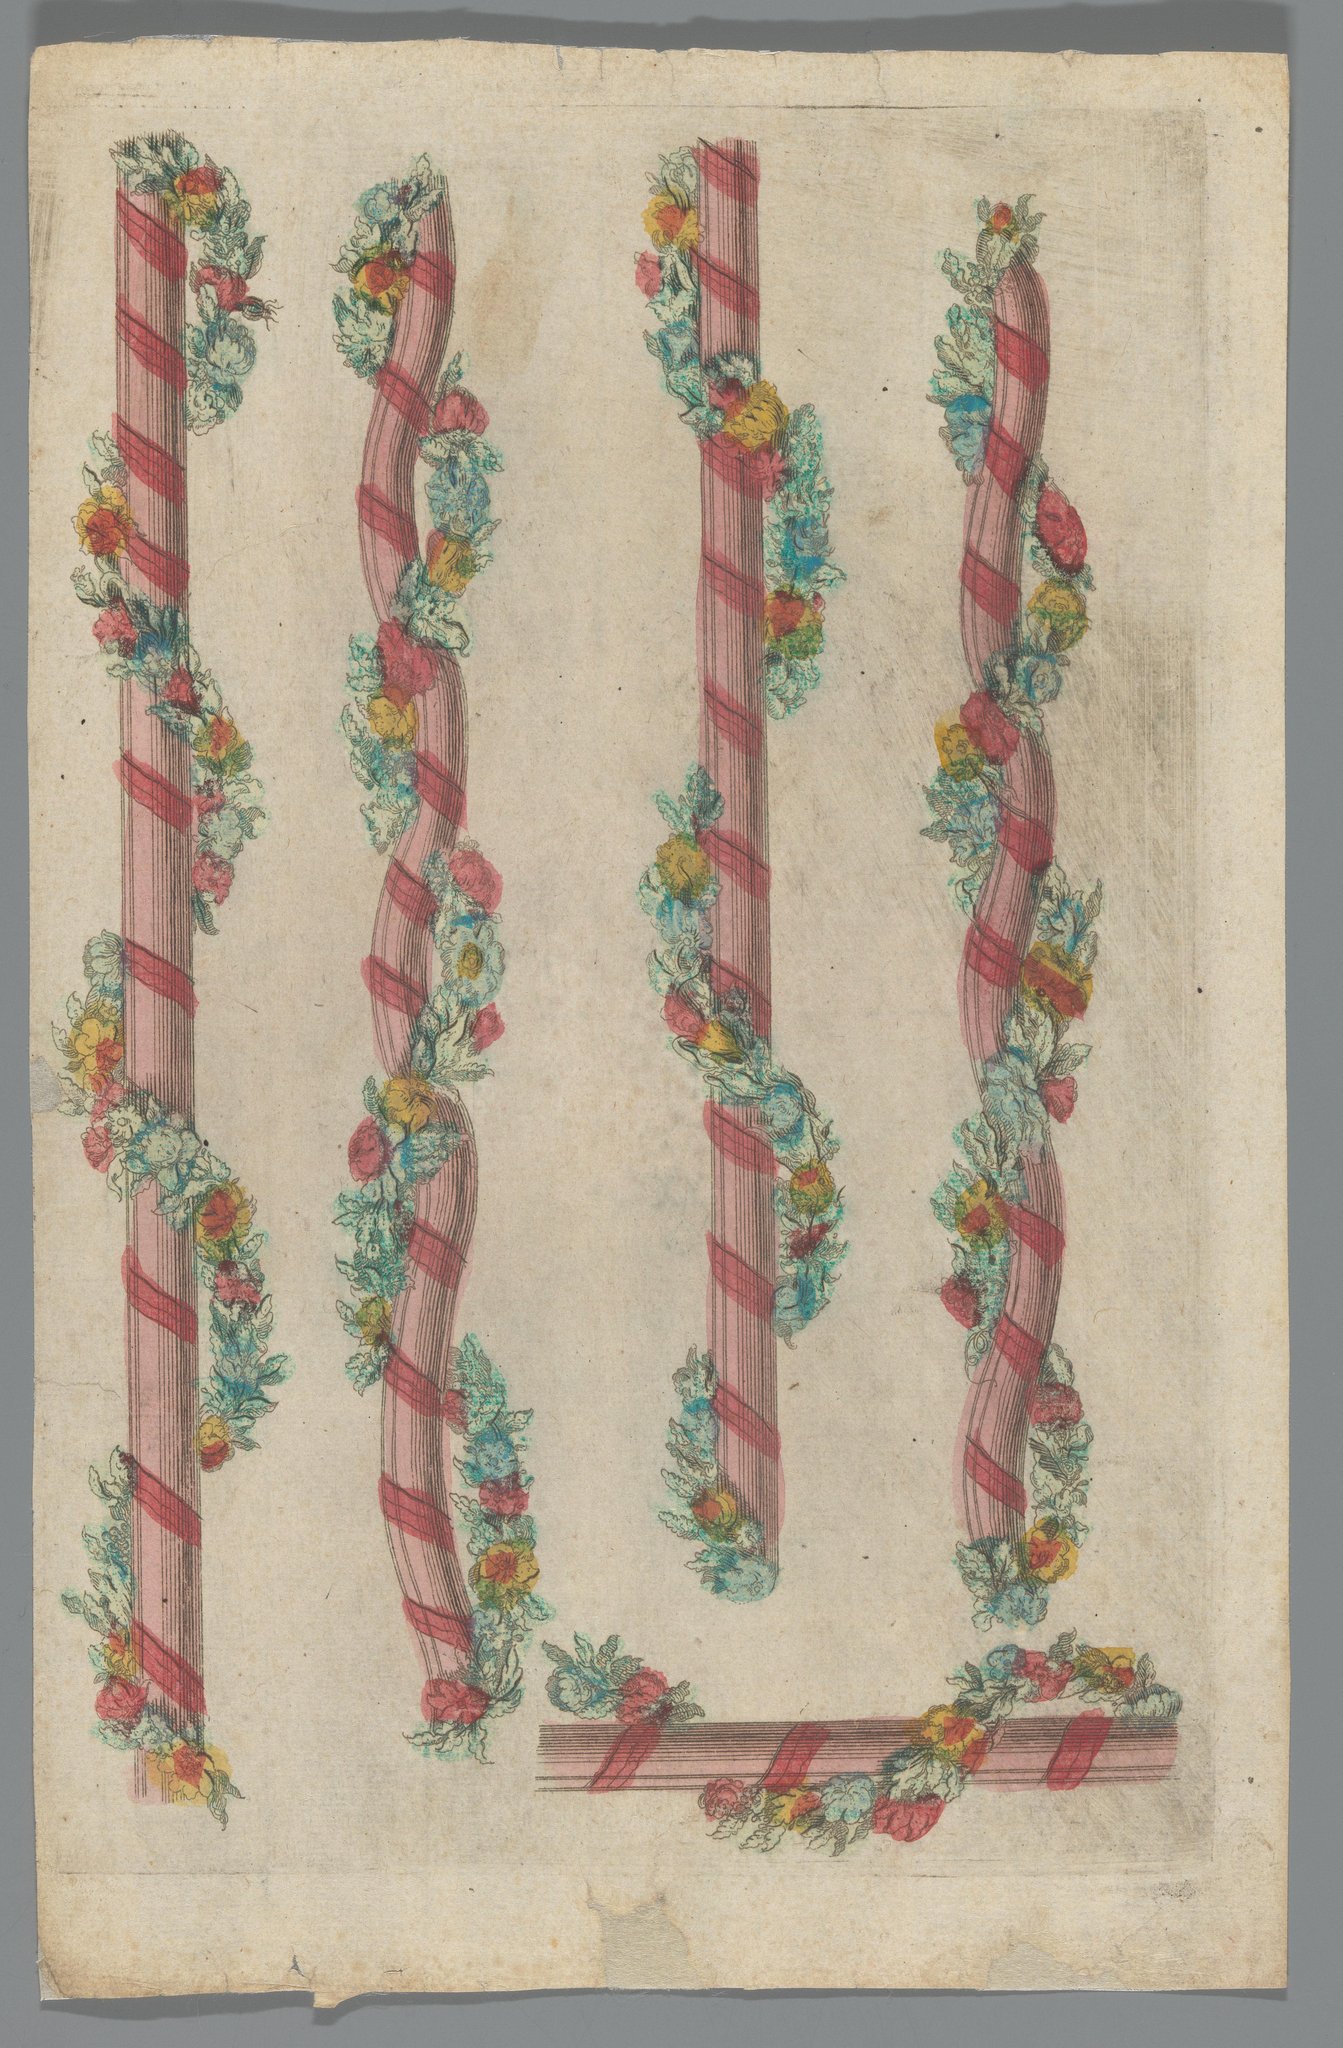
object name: print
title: Bladen met knipplaatjes en decoratieve randen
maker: Anonymous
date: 1750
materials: paper, watercolor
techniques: etching, hand coloring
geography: paris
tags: ornament derived from plant forms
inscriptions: collector's mark: Lugt 2228, collector's mark: Lugt 2760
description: Vijf staven met omwikkeld met guirlandes. Een van 39 bladen met knipplaatjes en decoratieve randen.